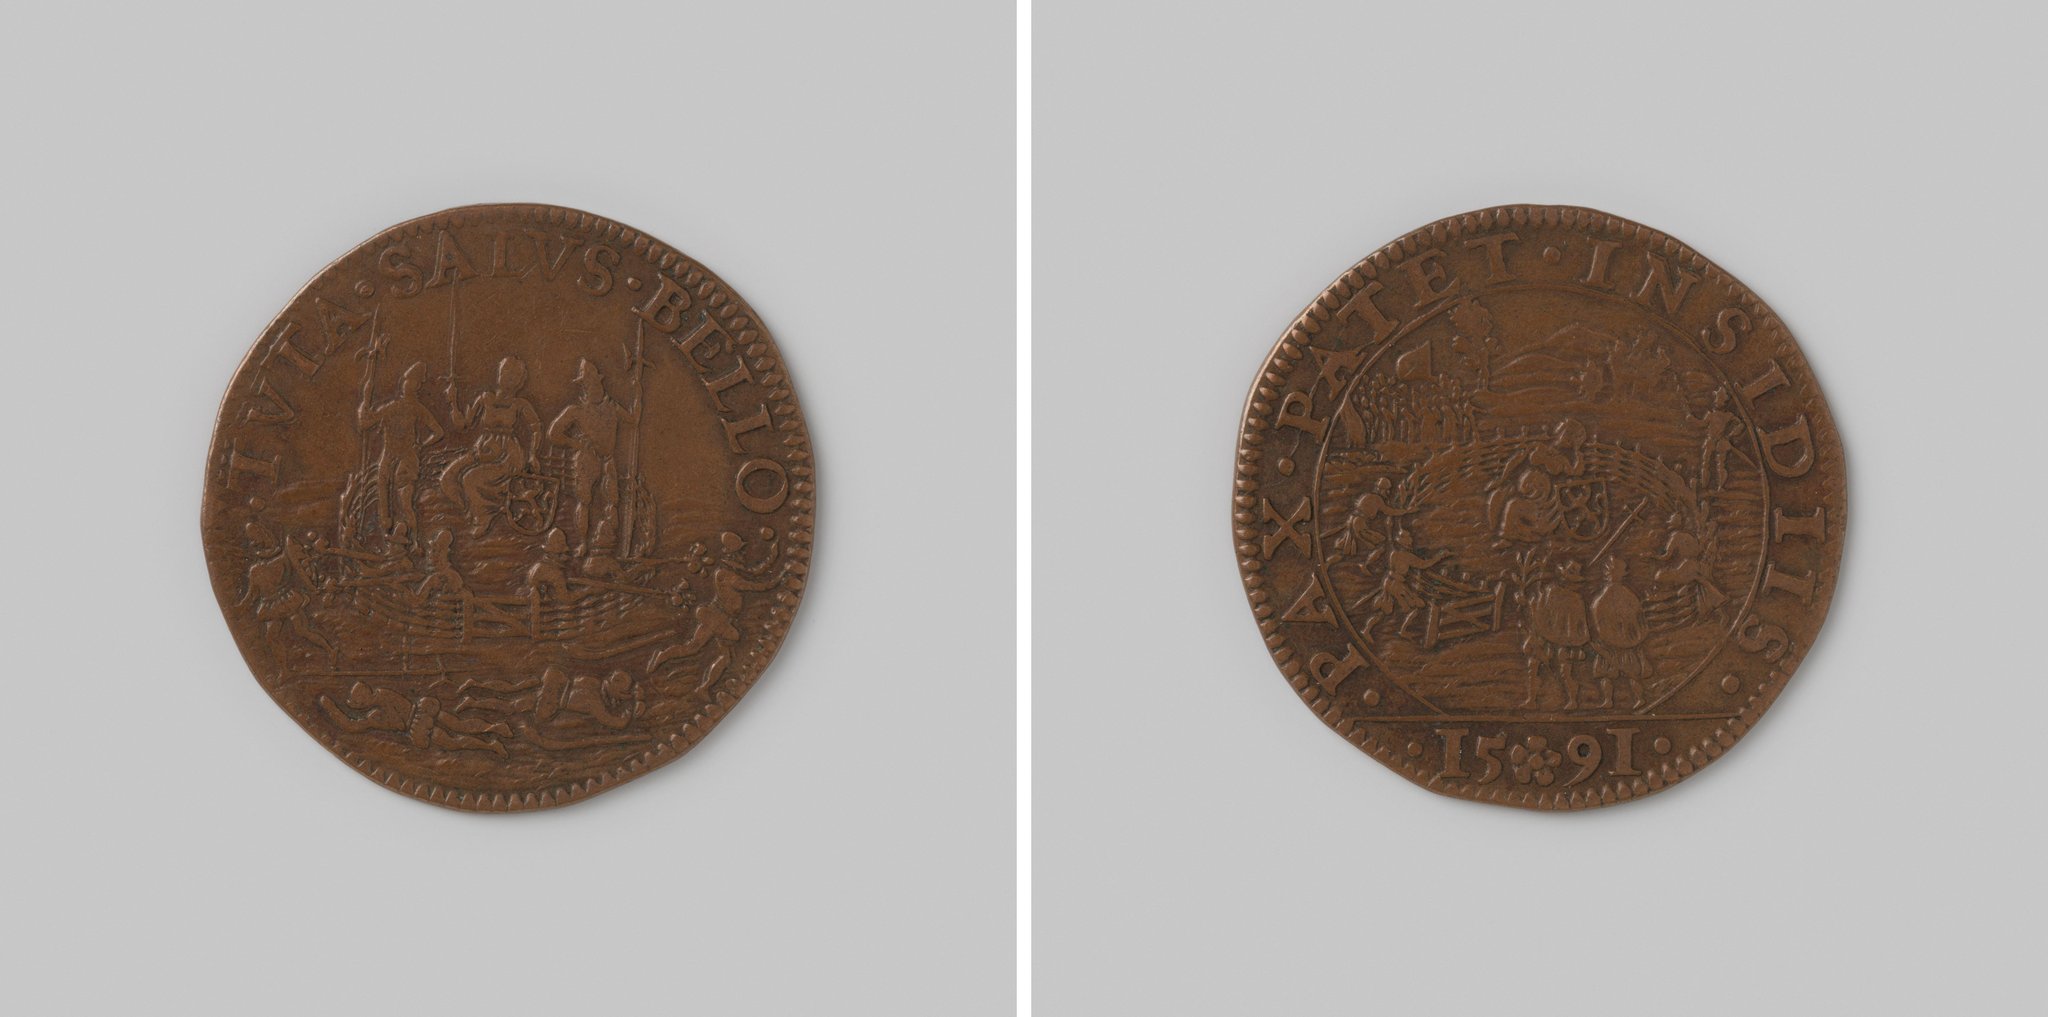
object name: history medal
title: Rekenpenning uit Dordrecht op het aanbieden van vrede door Spanje 1591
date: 1591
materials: copper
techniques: striking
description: Koperen penning, op de voorzijde de Hollandse maagd met soldaten in een omheinde tuin, belaagd door vijanden, met omschrift, op de keerzijde de rustende maagd in een openstaande tuin met vrienden, met omschrift en afsnedetekst.